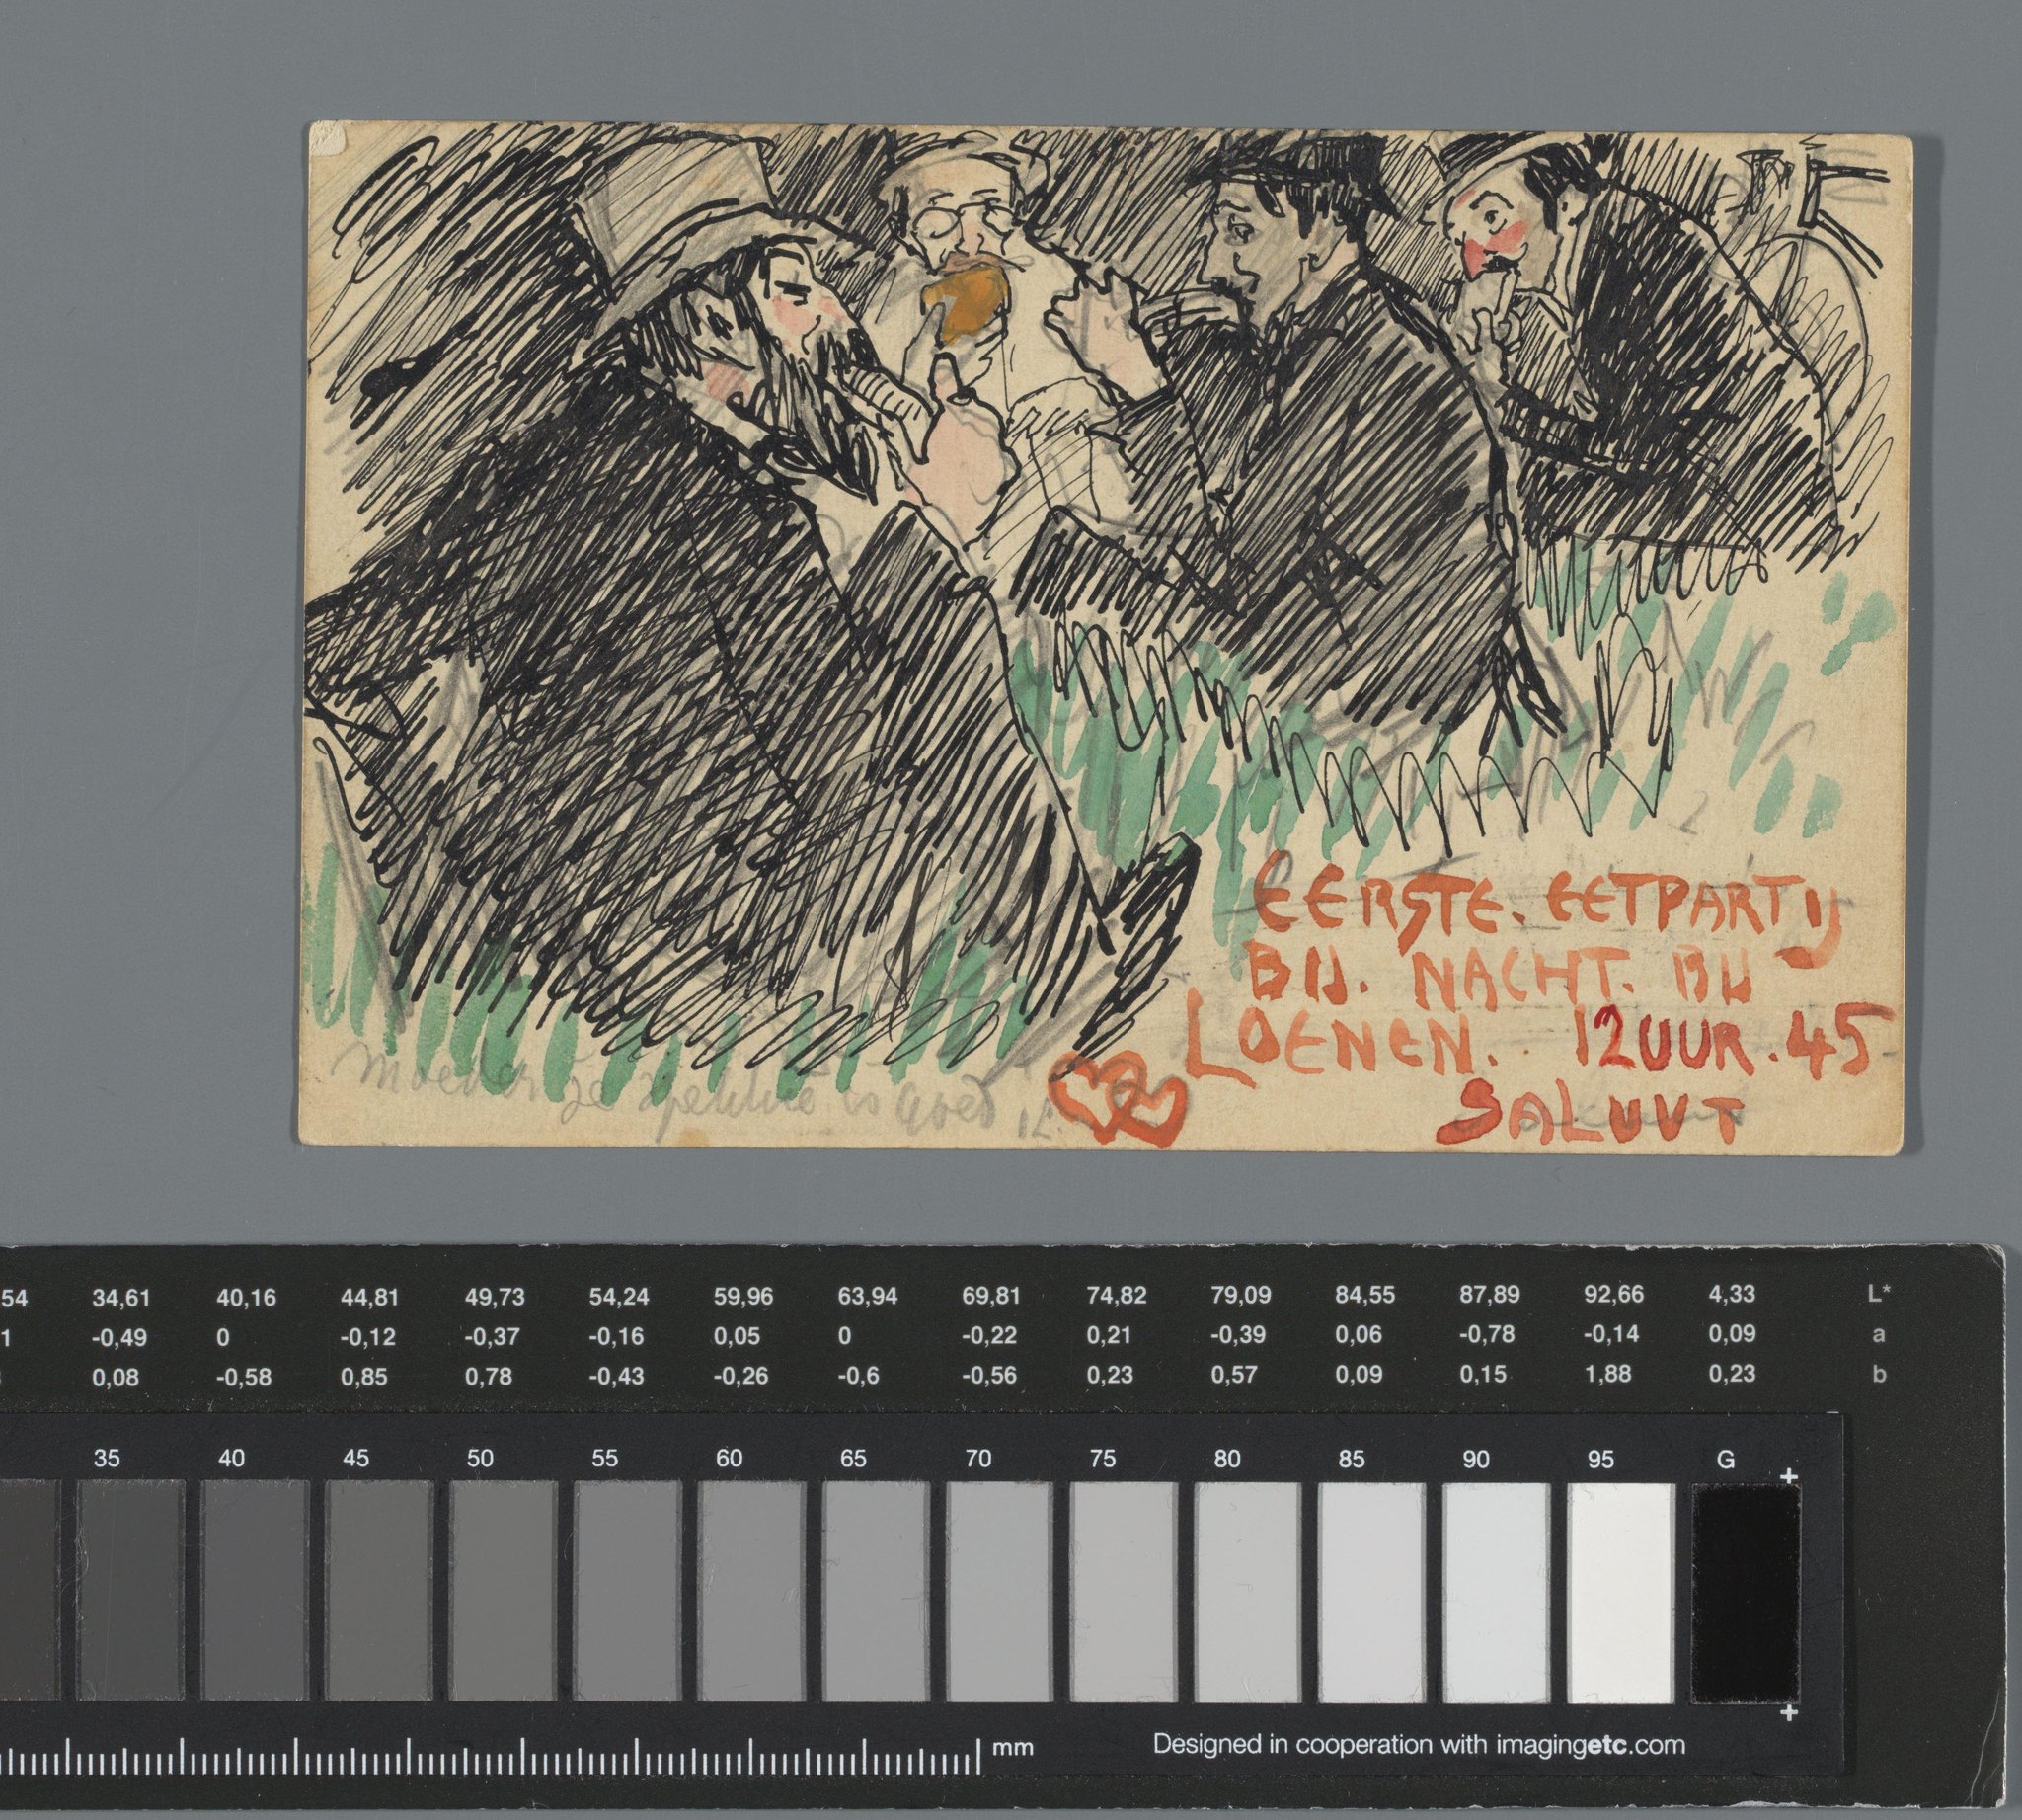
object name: drawing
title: Eerste eetpartij bij nacht bij Loenen 12 uur 45. Saluut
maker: leo gestel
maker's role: draughtsman, print maker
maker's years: 1881-1941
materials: cardboard, ink, pencil, watercolor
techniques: brush, pen, writing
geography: nieuwersluis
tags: henriëtte johanna petronella ponstijn-van hilten, print maker, draughtsman, jan petrus ponstijn, leo gestel, eating and drinking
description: Briefkaart met een tekening van vier mannen, waaronder Jan Ponstijn en Leo Gestel, die zitten te eten en drinken. Briefkaart maakt deel uit van een album.